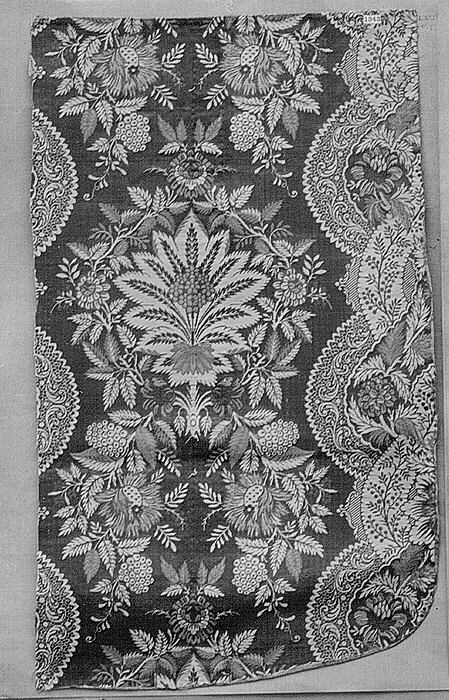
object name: piece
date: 1725-1730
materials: silk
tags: flowers,leaves